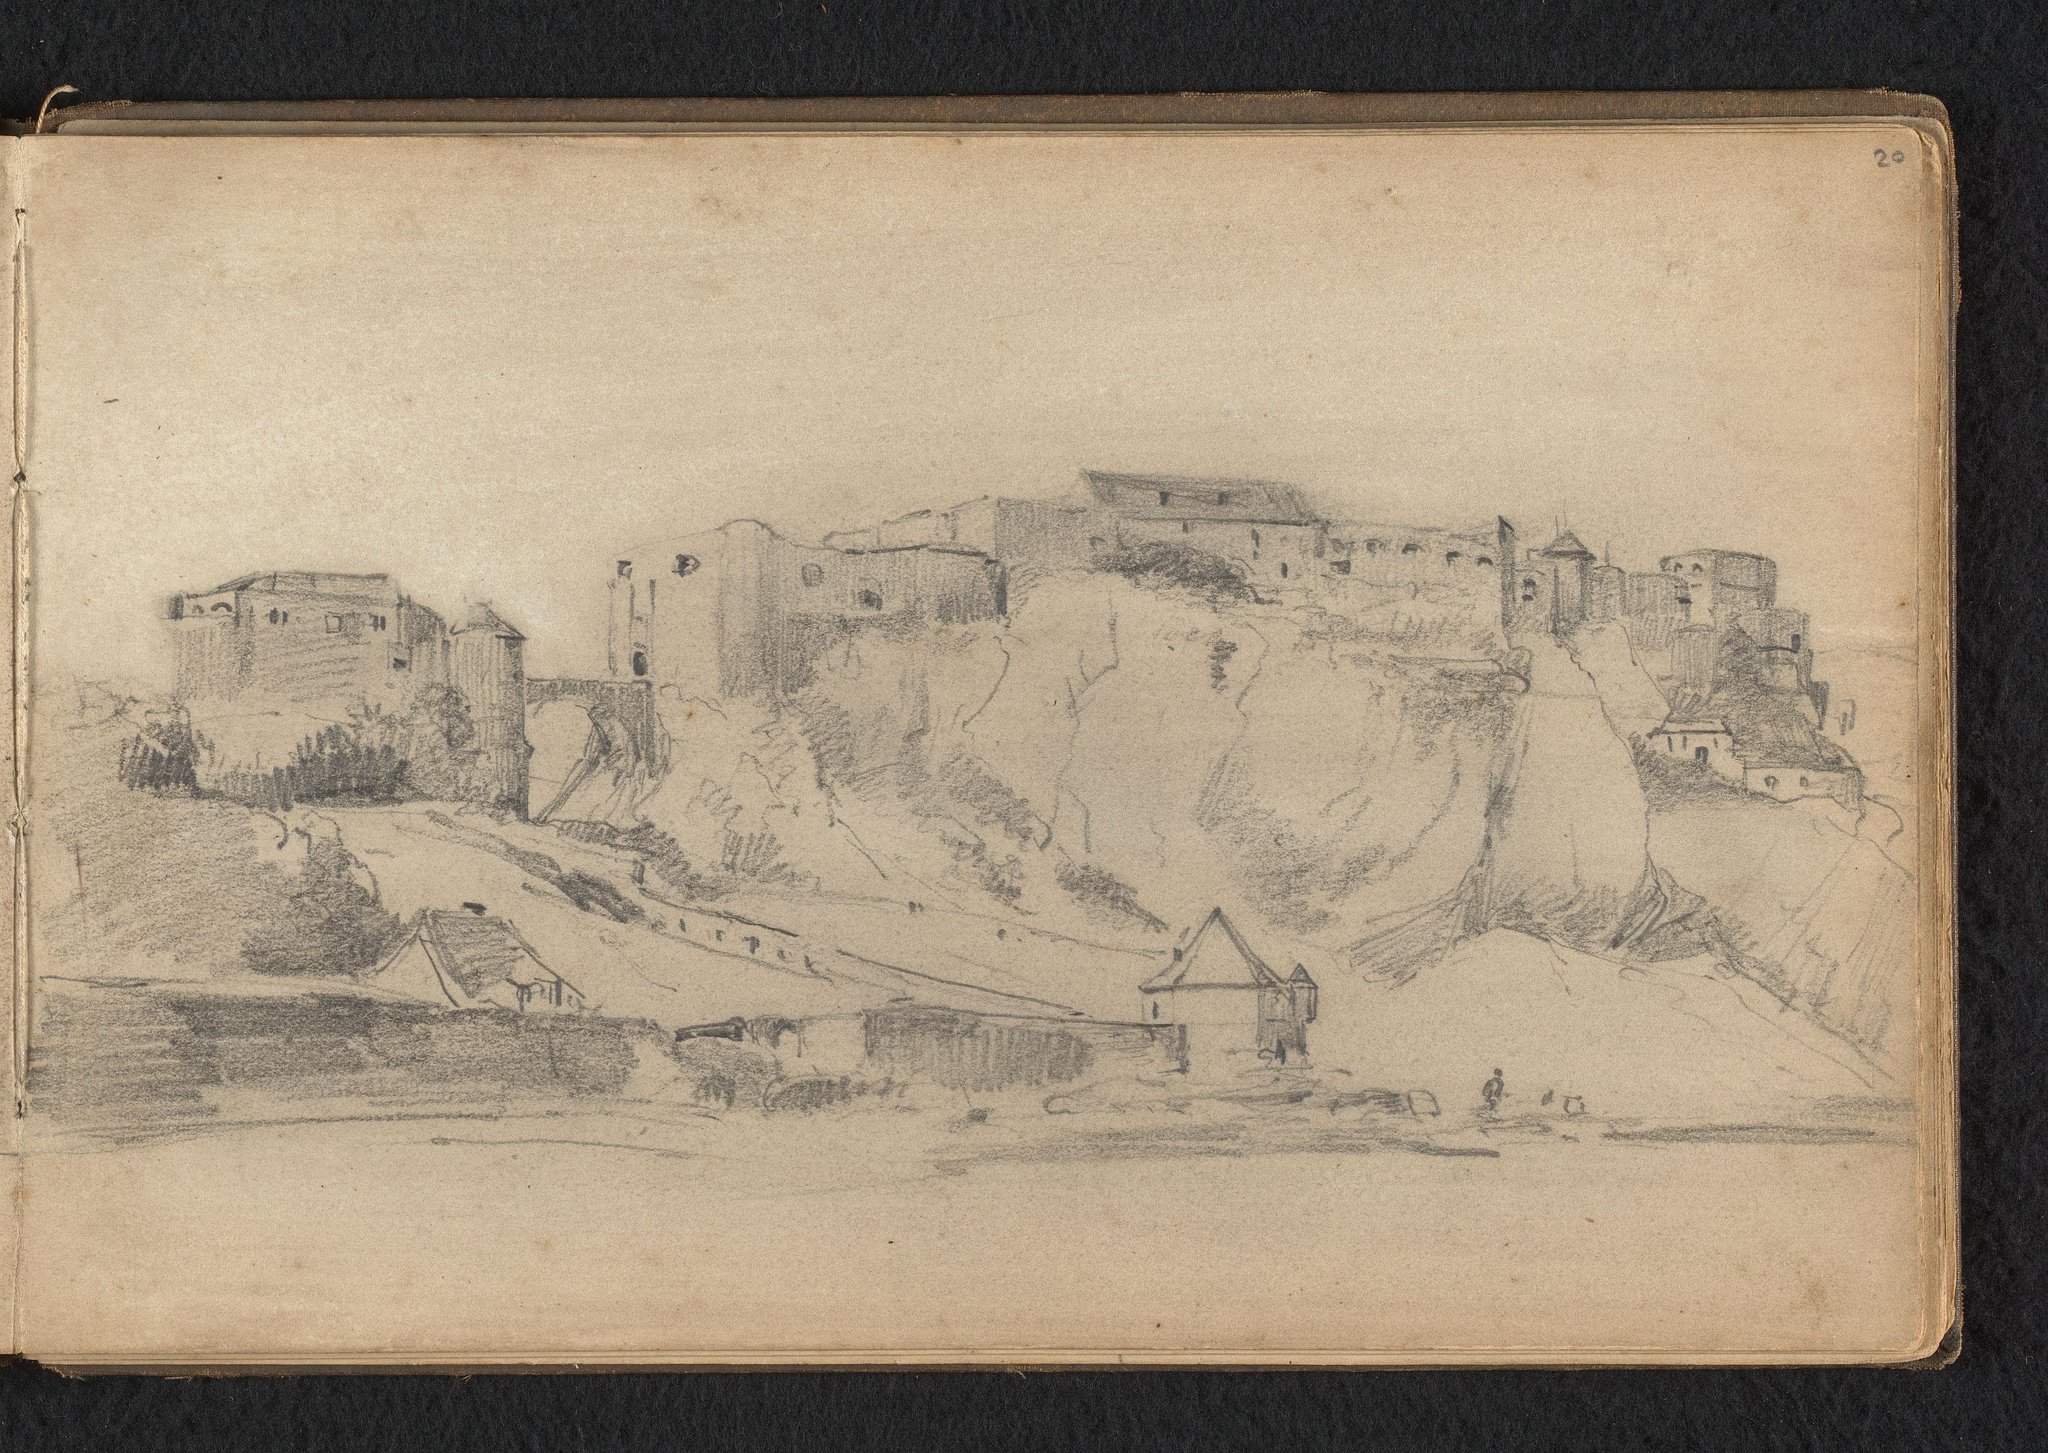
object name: sketchbook leaf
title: Gezicht op een dorp op een heuvel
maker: jan bedijs tom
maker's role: draughtsman, painter, print maker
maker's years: 1813-1894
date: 1823-1894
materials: paper, pencil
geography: the hague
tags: (high) hill, village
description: Pagina 20 recto uit een schetsboek met 37 bladen.